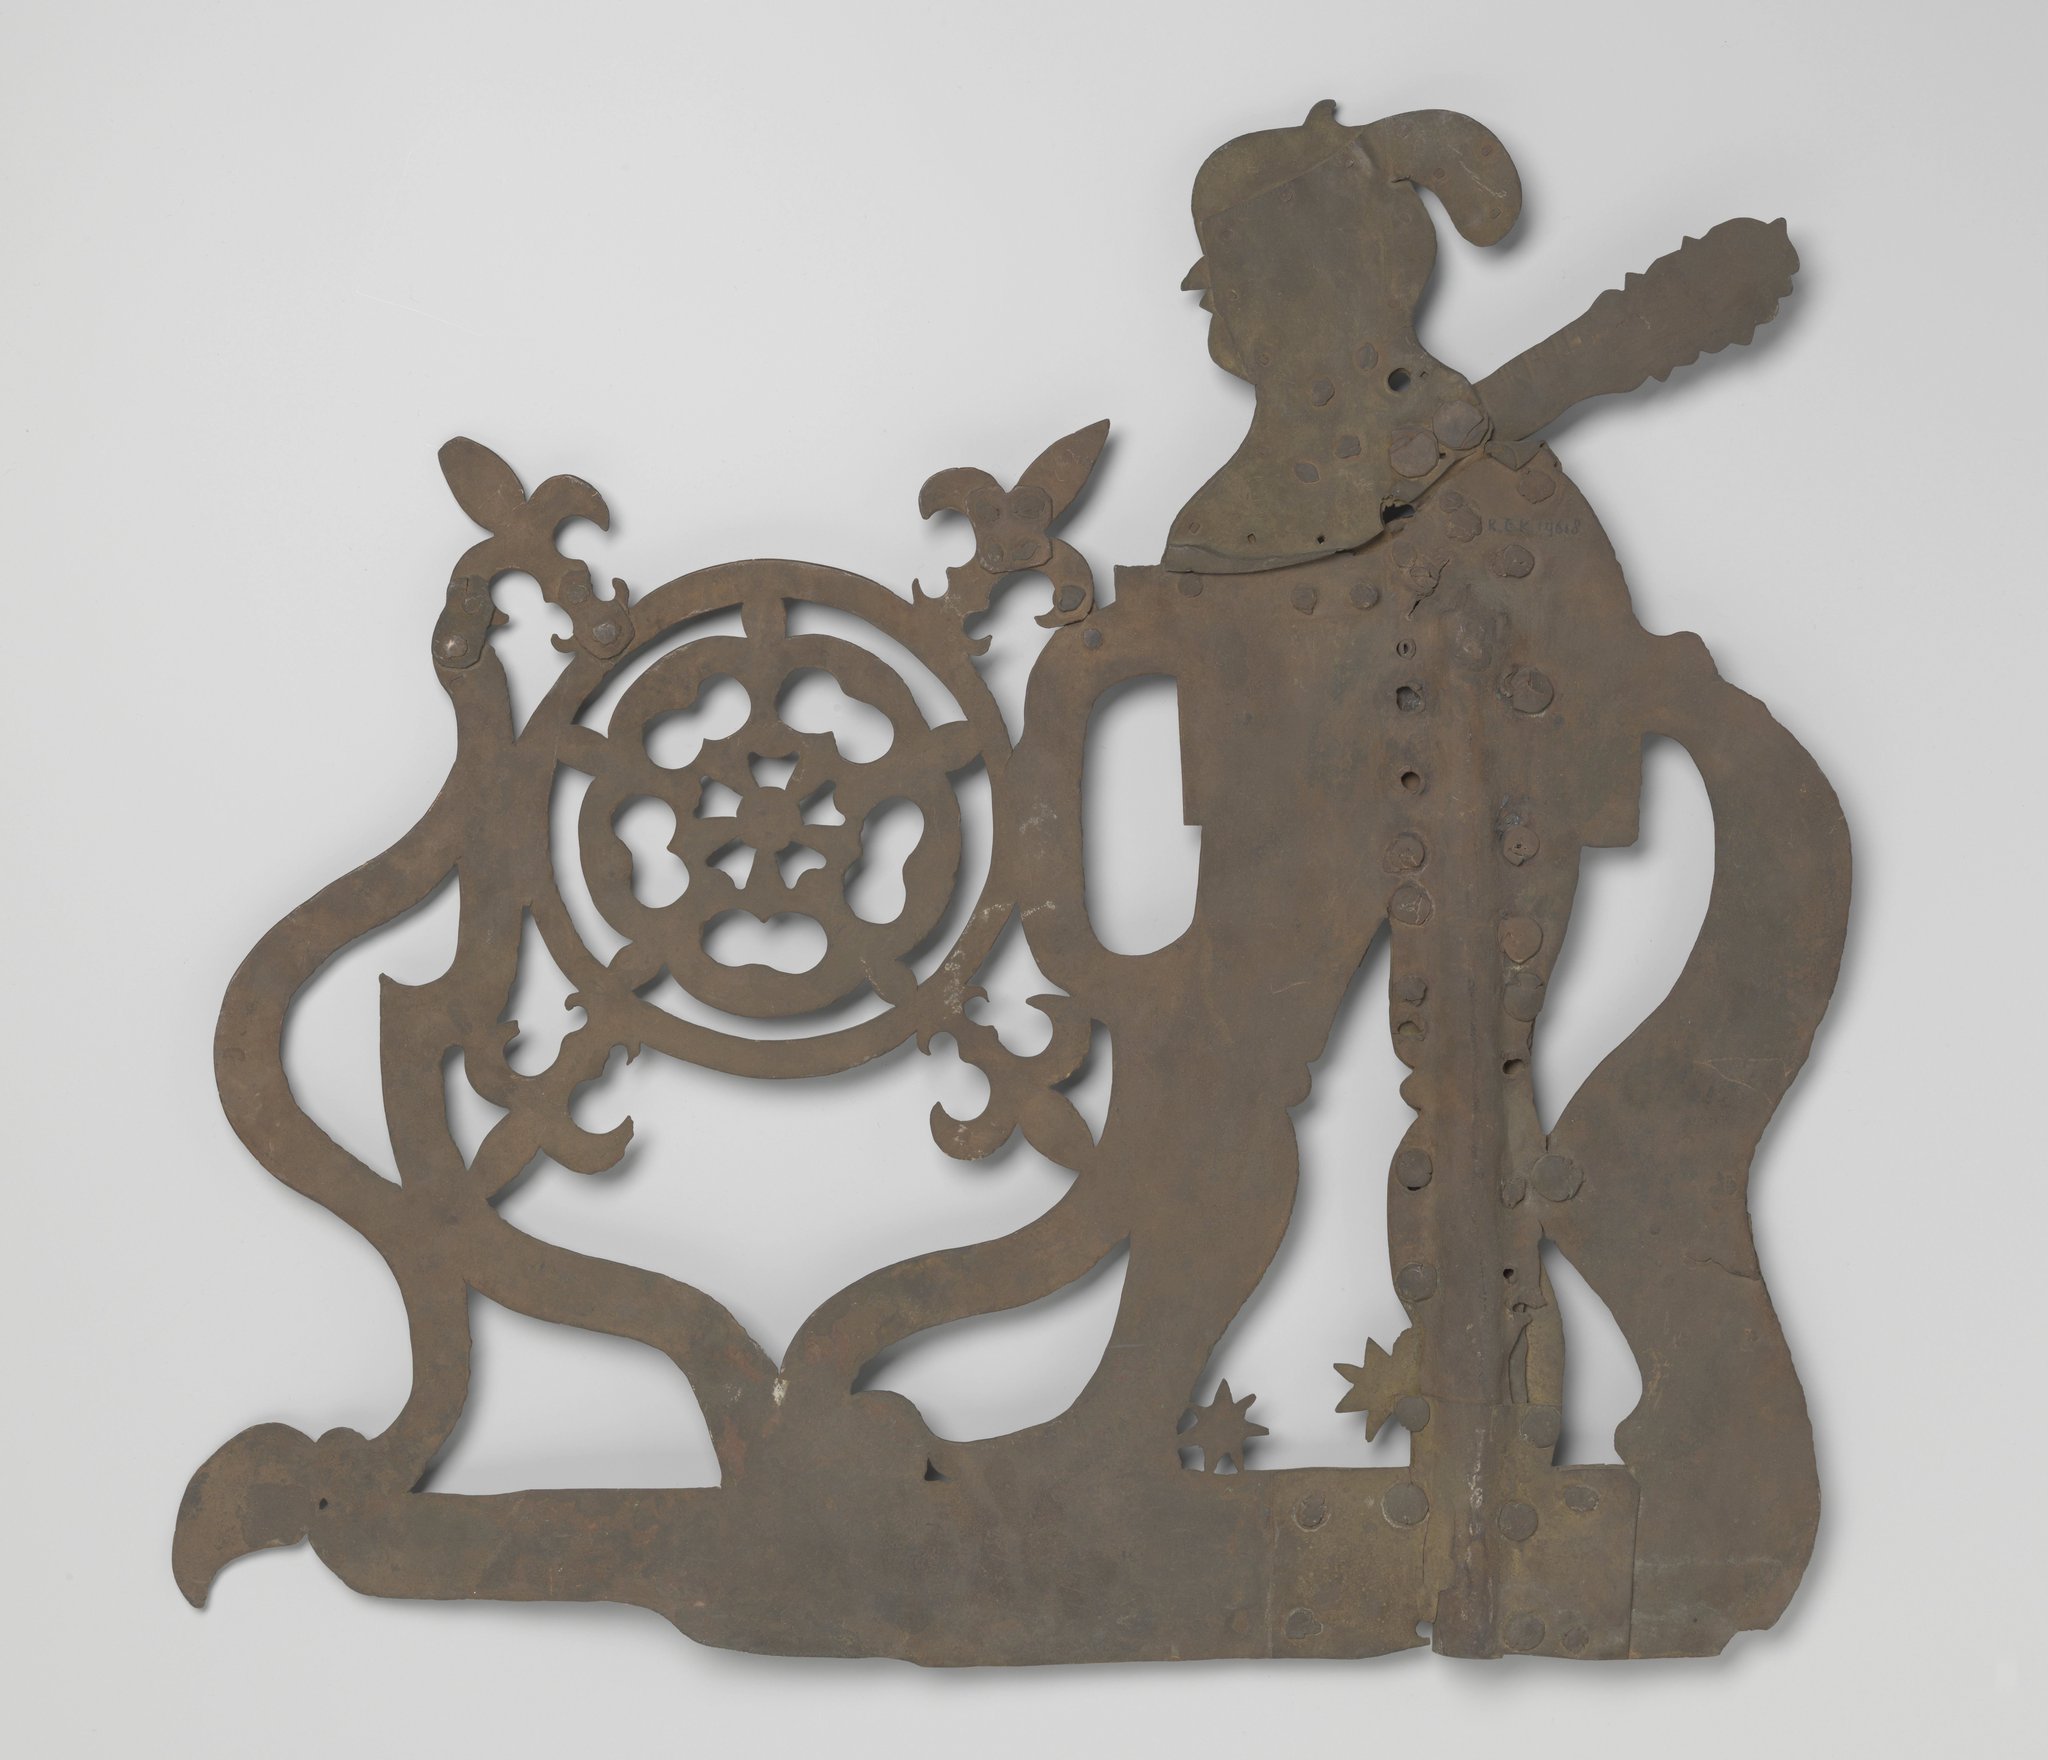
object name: weather vane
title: Windwijzer met figuur met knots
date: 1500-1600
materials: copper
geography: netherlands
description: Windvaan van rood koper. De vaan is a jour bewerkt en vertoont een tekening van een rozet in een cirkel en lelie in de diagonalen; verder slingerende lijnen en een verbasterde figuur, waarvan de profielkop van geel koper evenals een gedeelte van de koker later toegevoegd zijn.